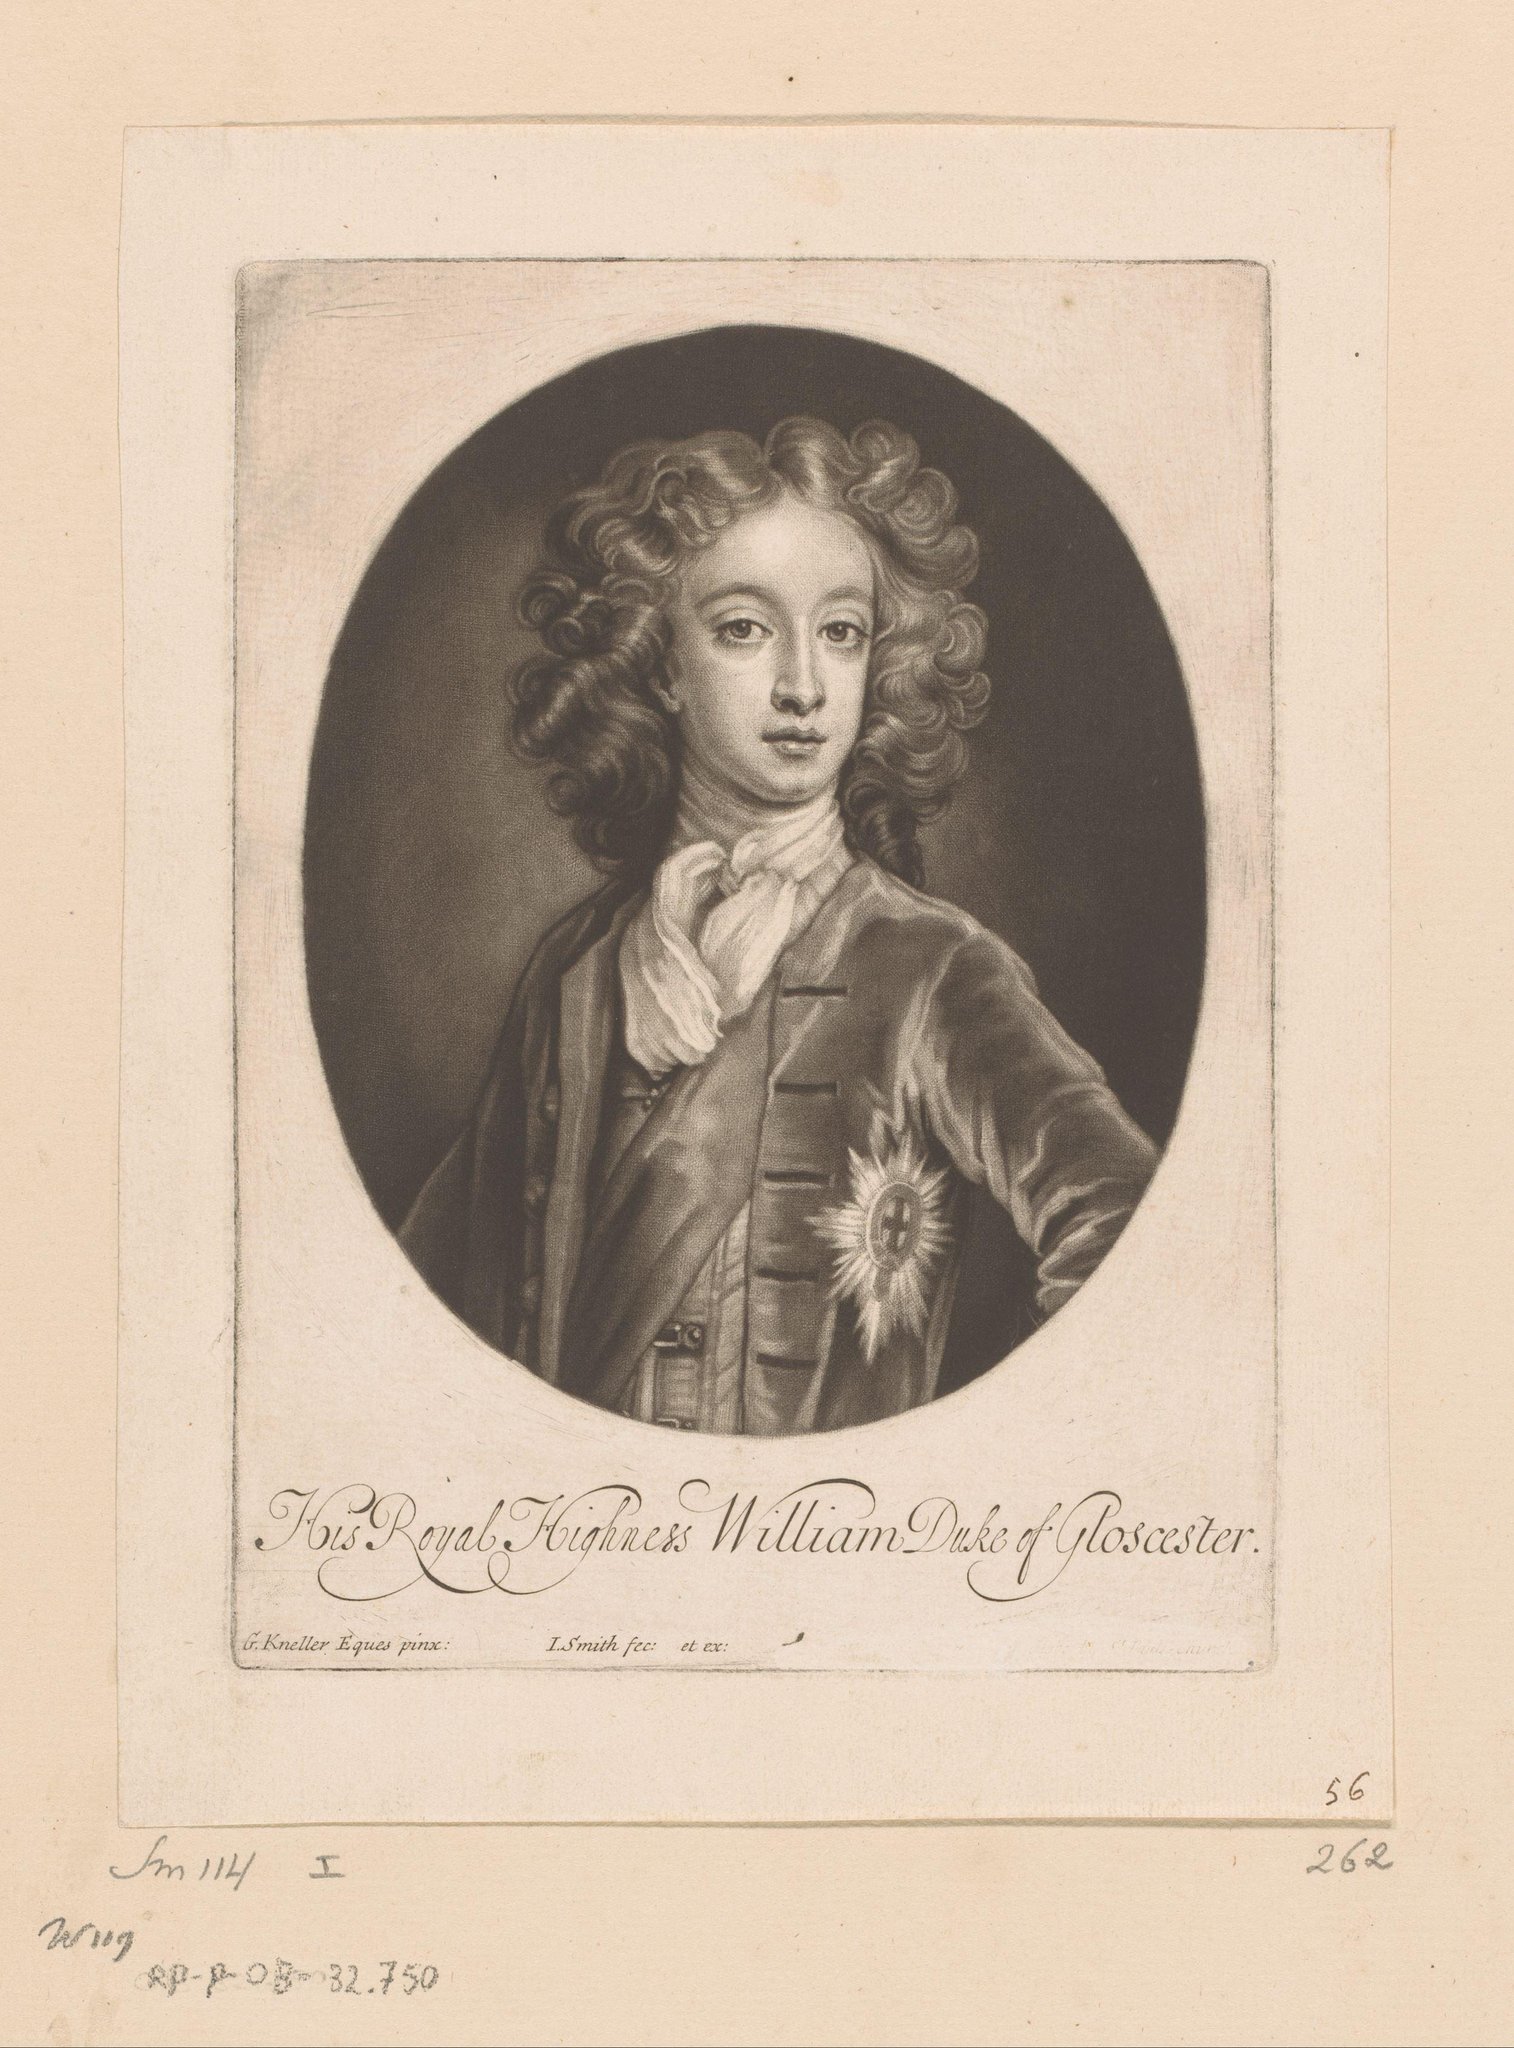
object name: print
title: Portret van William, hertog van Gloucester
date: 1695-1742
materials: paper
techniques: mezzotint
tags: historical persons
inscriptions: collector's mark: Lugt 240